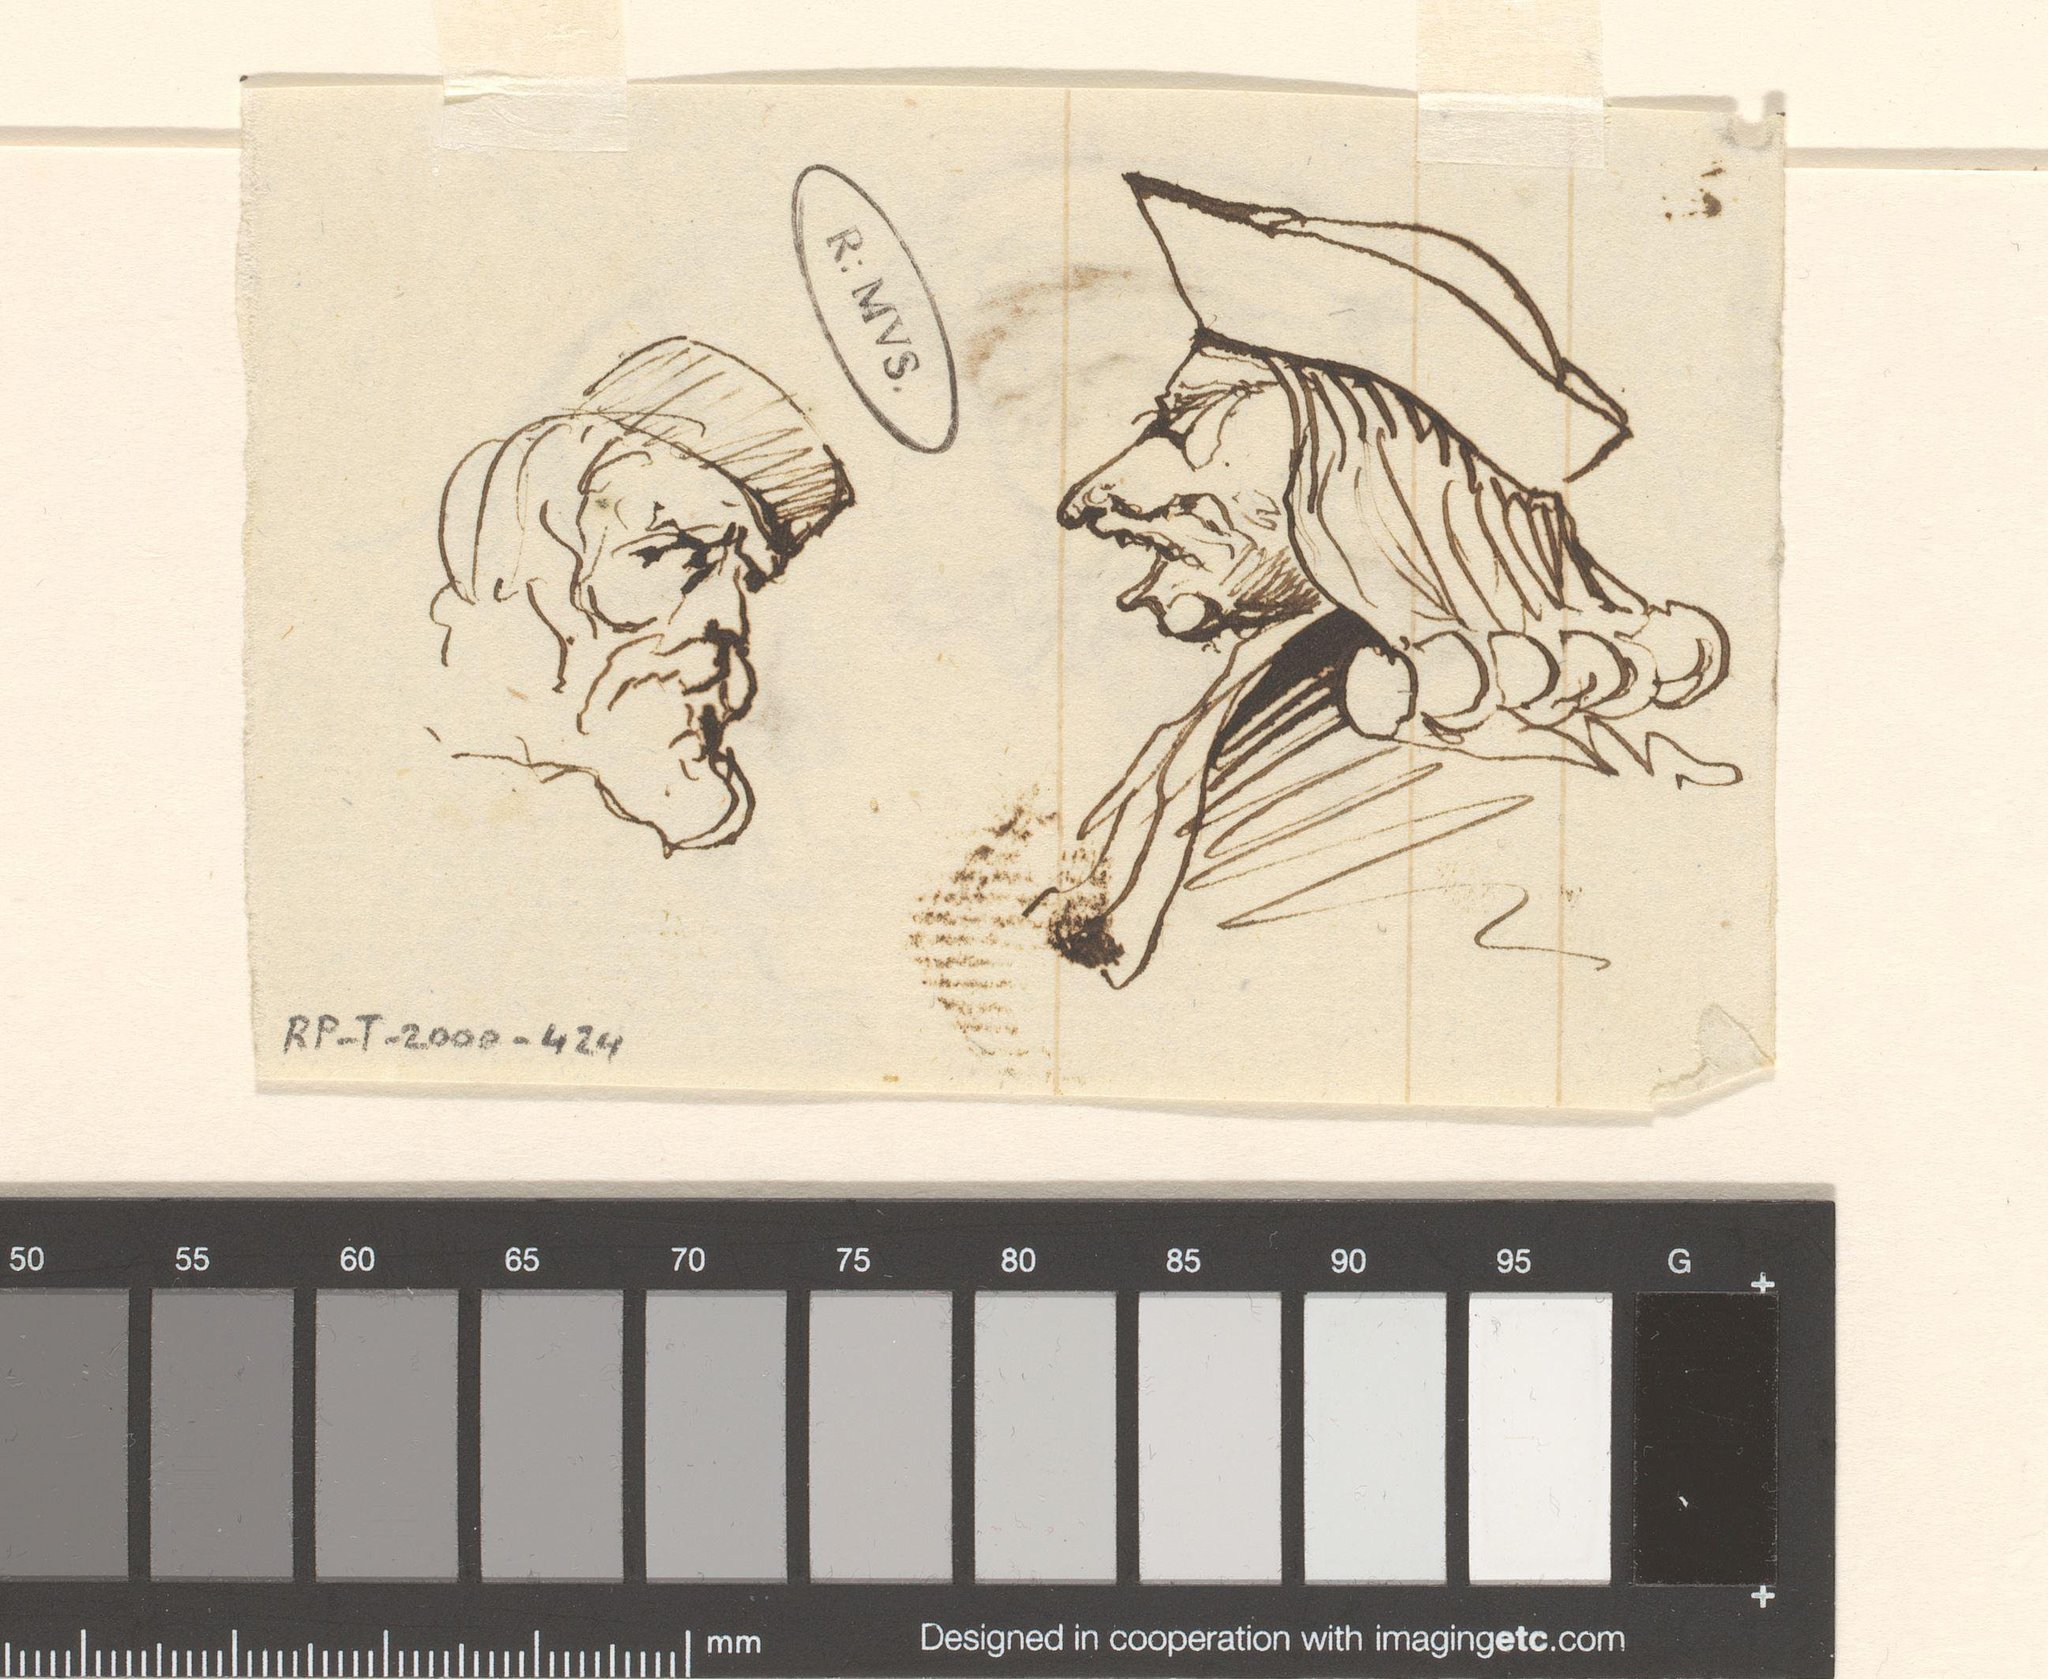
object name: drawing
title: Twee koppen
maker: johannes tavenraat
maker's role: draughtsman, painter, print maker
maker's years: 1809-1881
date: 1840-1880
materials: ink, paper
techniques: pen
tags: caricatures (human types)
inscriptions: collector's mark: Lugt 2228